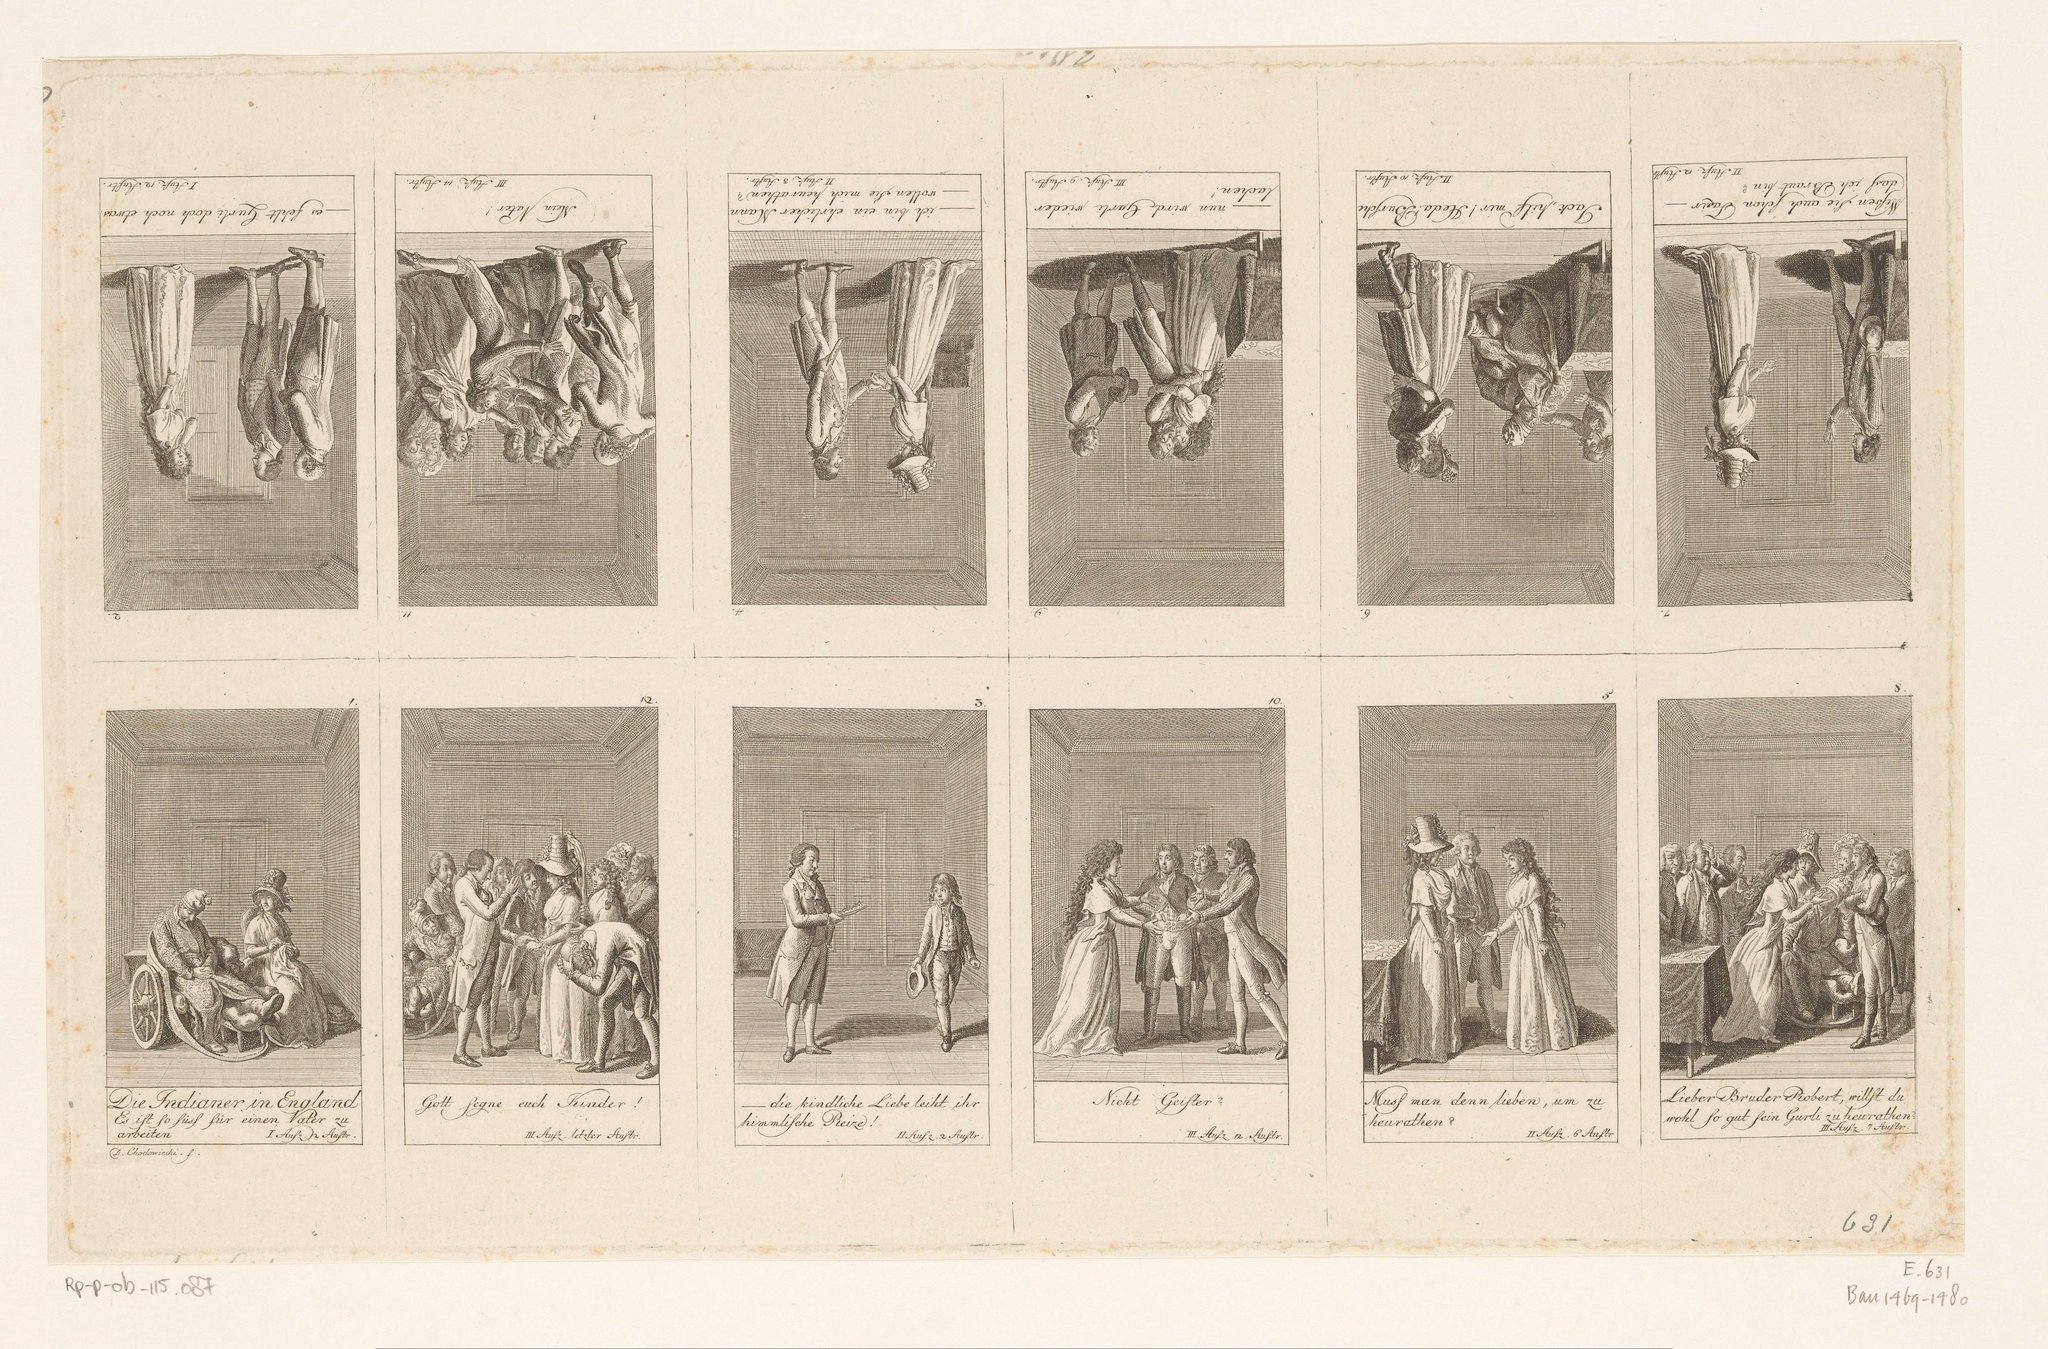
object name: book illustration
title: Twaalf voorstellingen uit 'De Indianen in Engeland' van August von Kotzebue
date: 1790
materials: paper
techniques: etching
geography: berlin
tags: literature, (lovers) embracing each other, 'symplegma', family, descendance, native peoples of the americas, betrothal and marriage, conversation, dialogue; conversation piece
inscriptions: collector's mark: Lugt 2228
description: Vervaardigd voor 'De Indianen in Engeland' van August von Kotzebue. Prenten gebruikt in: Königl. Grosbritannischer Historischer Genealogischer Calender für 1791. Lauenburg: Berenberg, [1790].